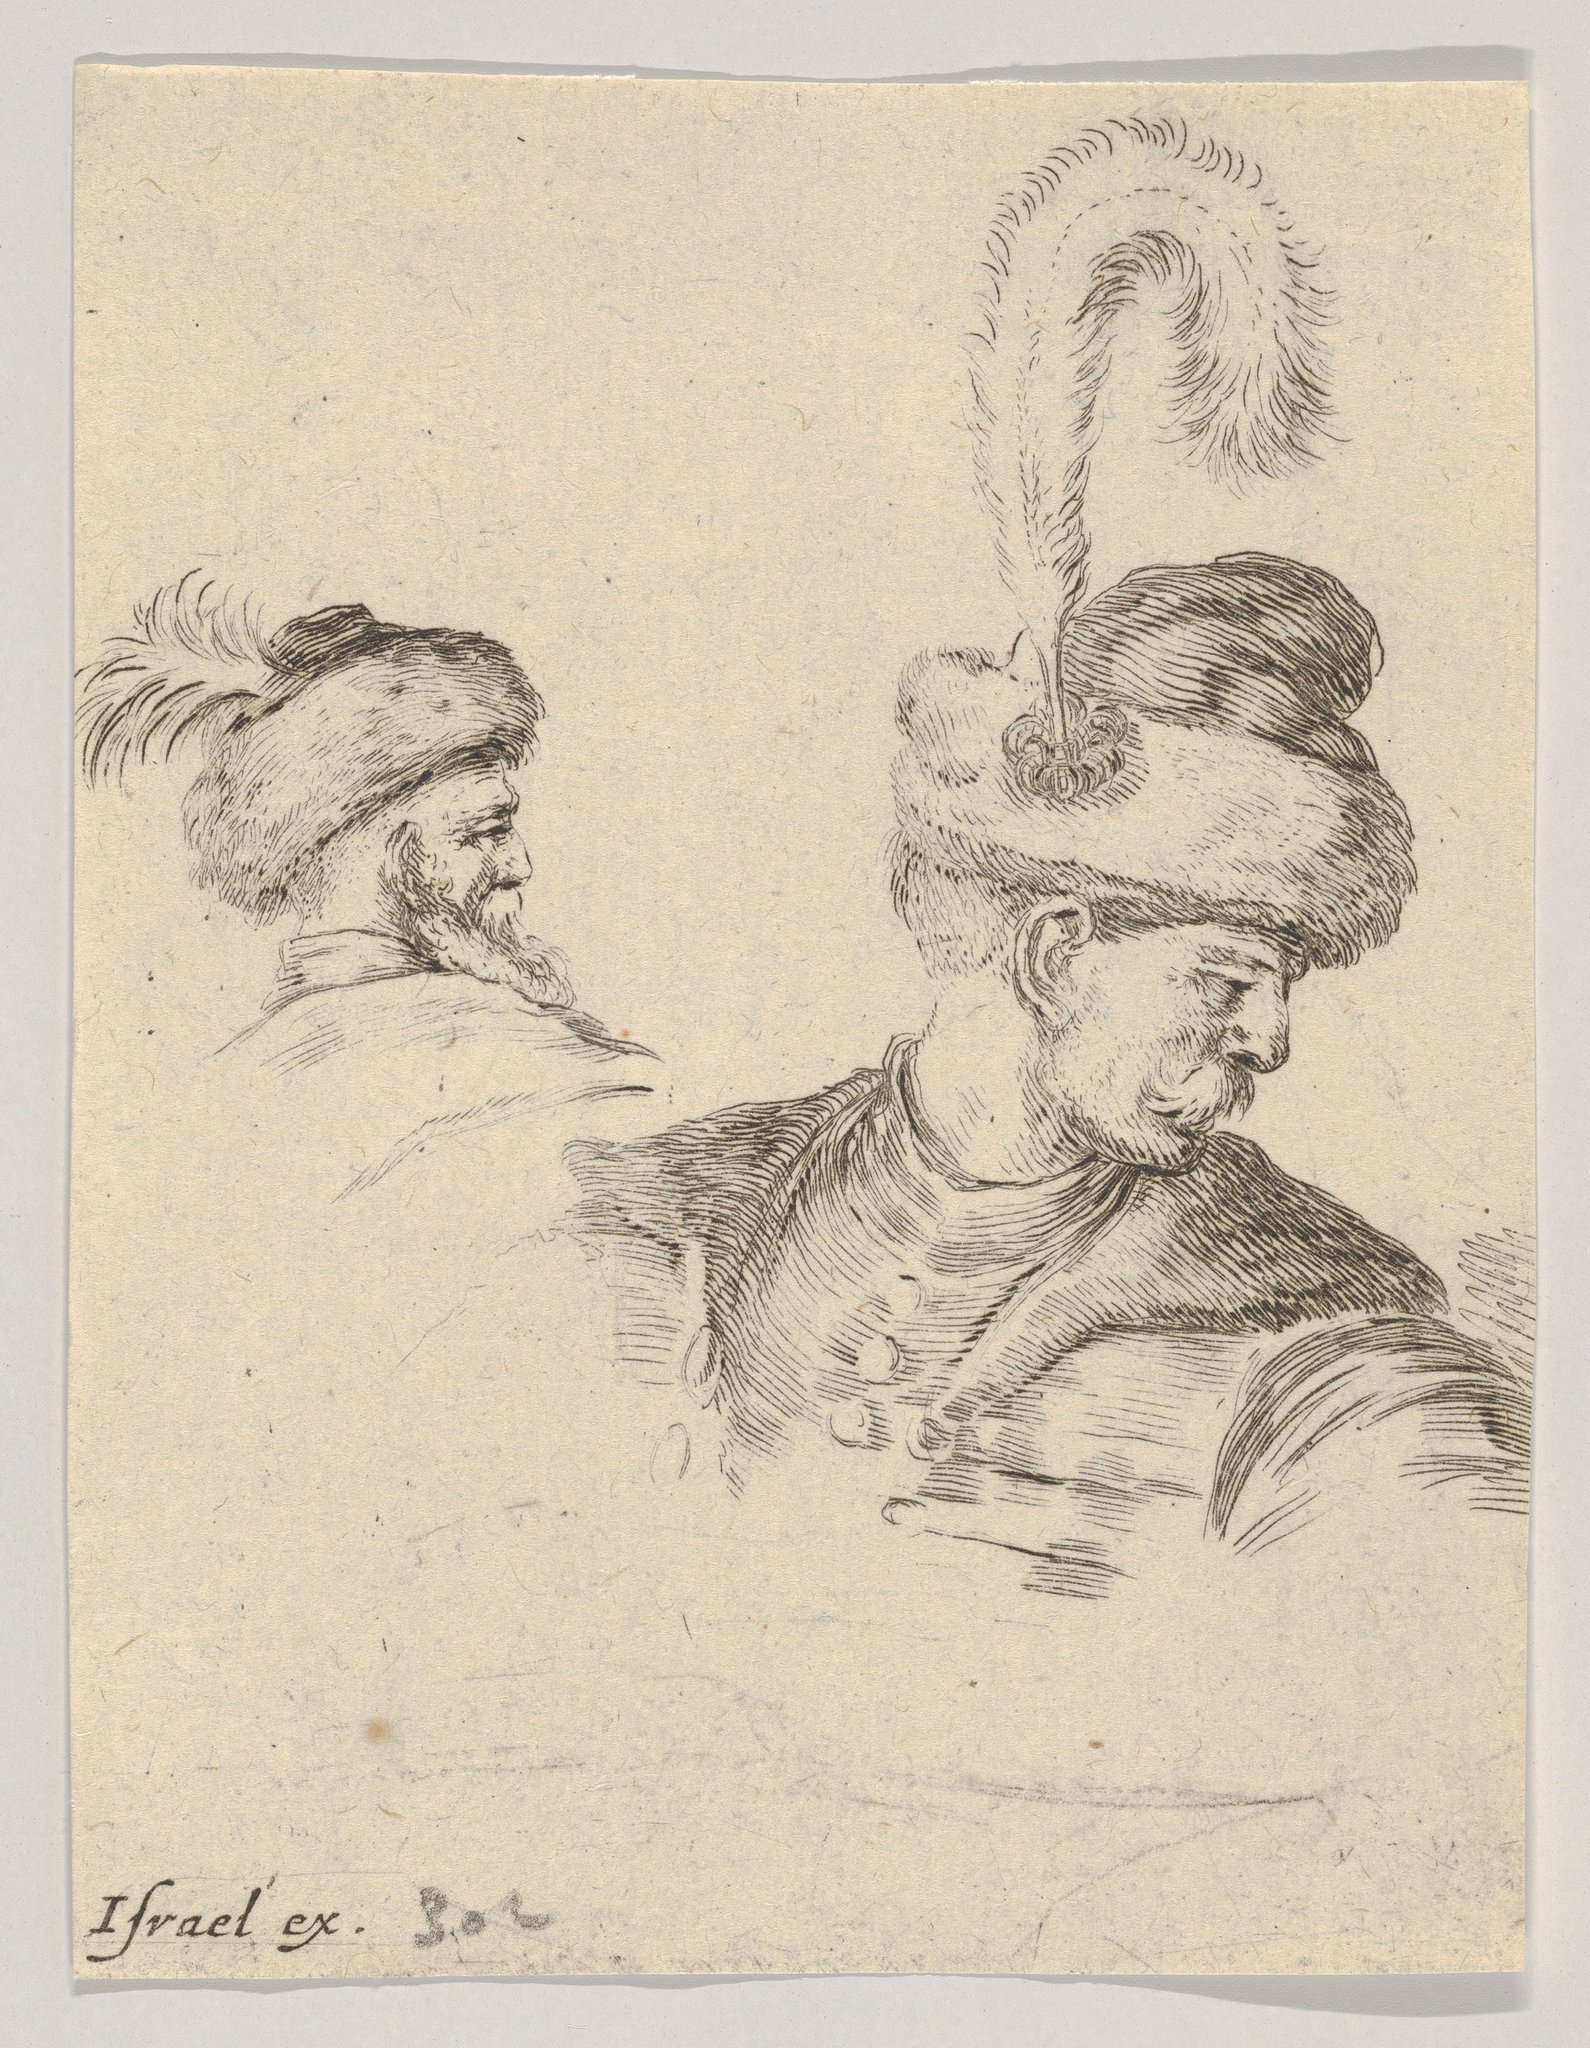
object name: print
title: Plate 11: A Polish bust in profile, turned to the right, another Polish head seen from behind in the background, from "The Book for Learning to Draw" (Livre pour apprendre à dessiner)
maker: stefano della bella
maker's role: artist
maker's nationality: italian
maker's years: 1610-1664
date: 1649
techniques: etching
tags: men,profiles